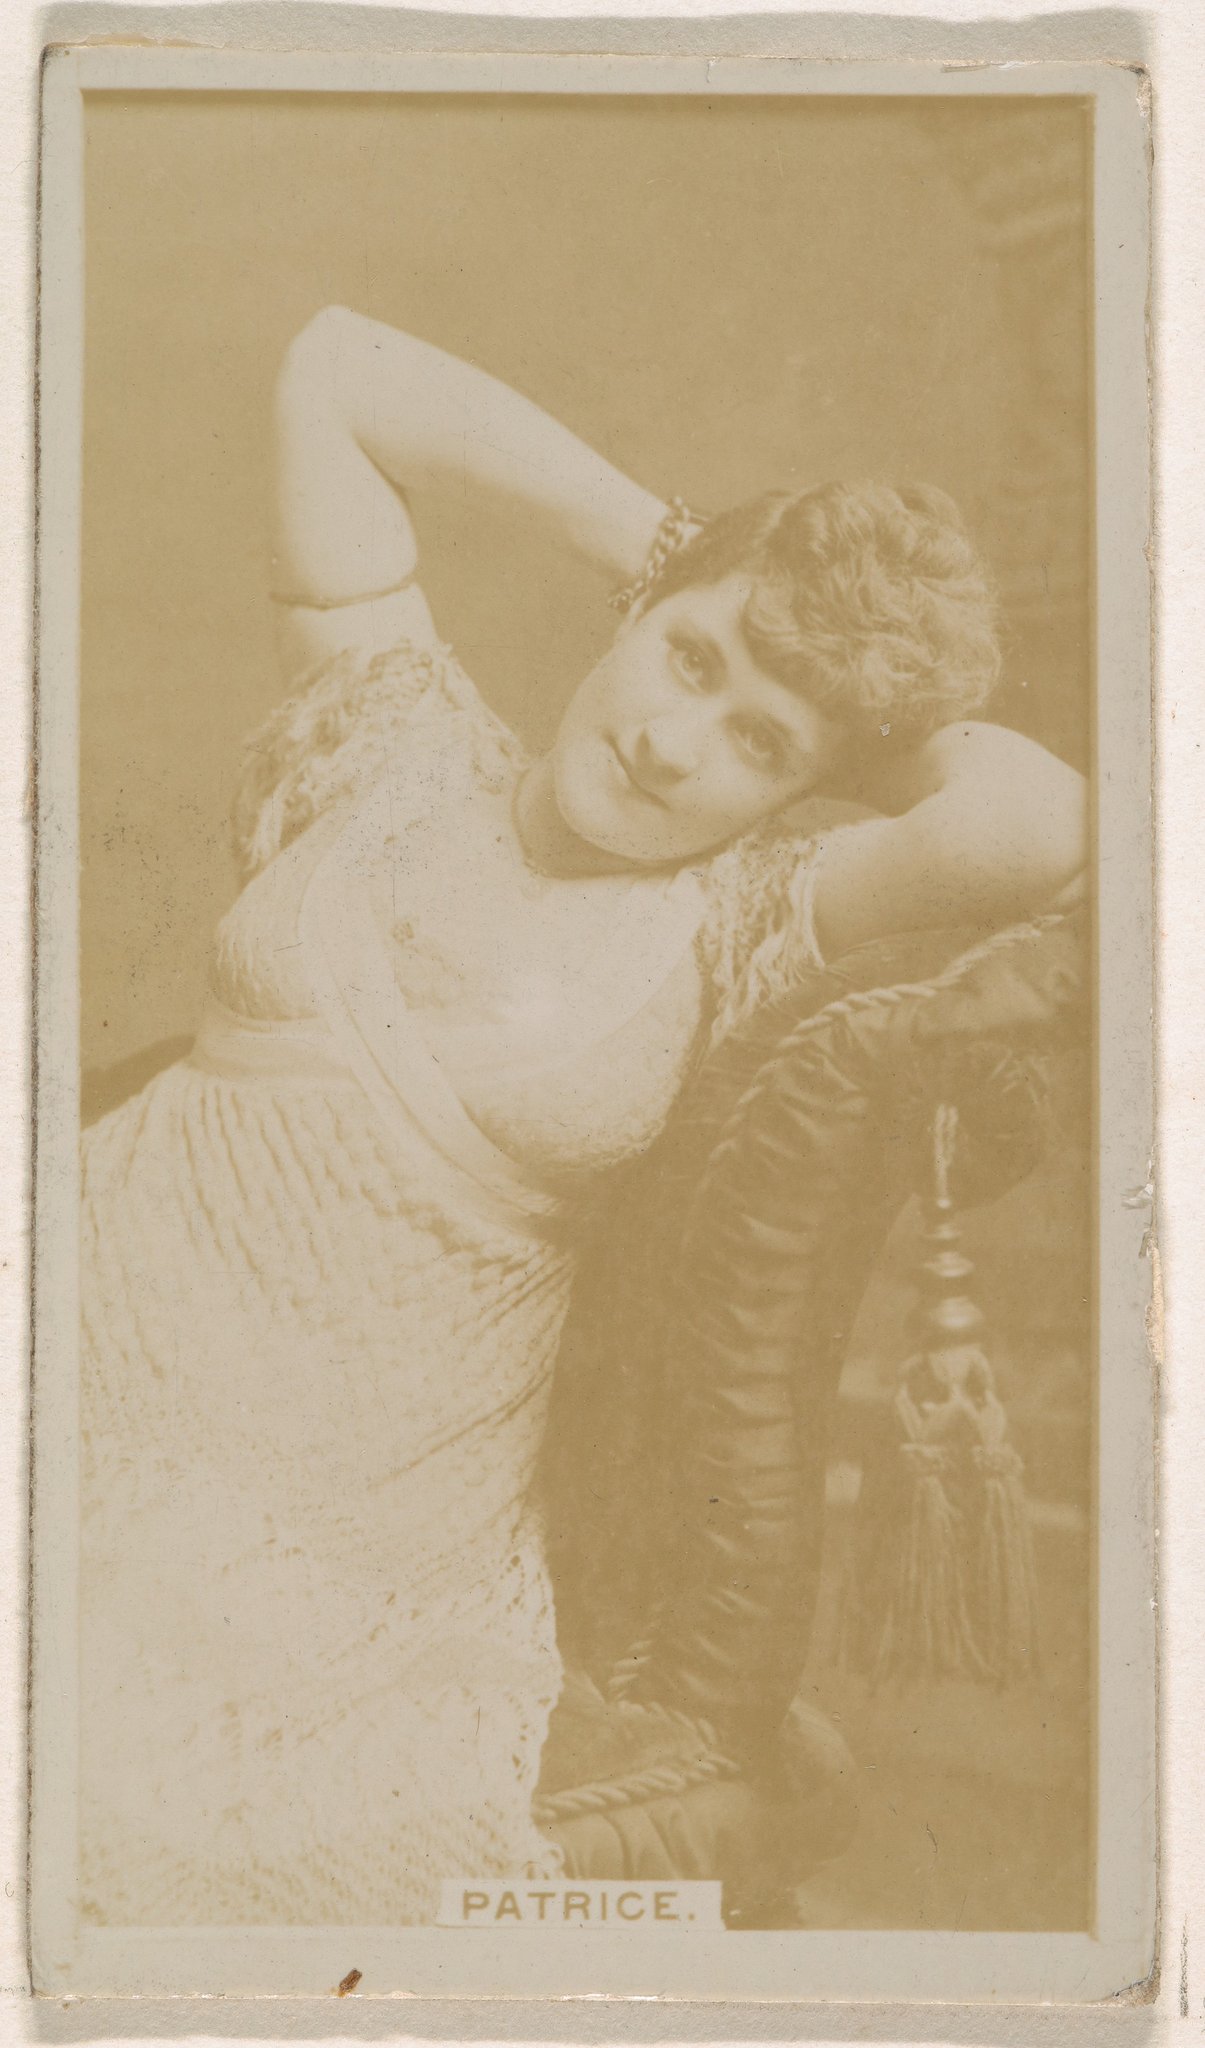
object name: photograph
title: Miss Patrice, from the Actresses series (N245) issued by Kinney Brothers to promote Sweet Caporal Cigarettes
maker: kinney brothers tobacco company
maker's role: publisher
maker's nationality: american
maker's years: 1869-2011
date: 1890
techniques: albumen silver print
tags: portraits,women,actresses